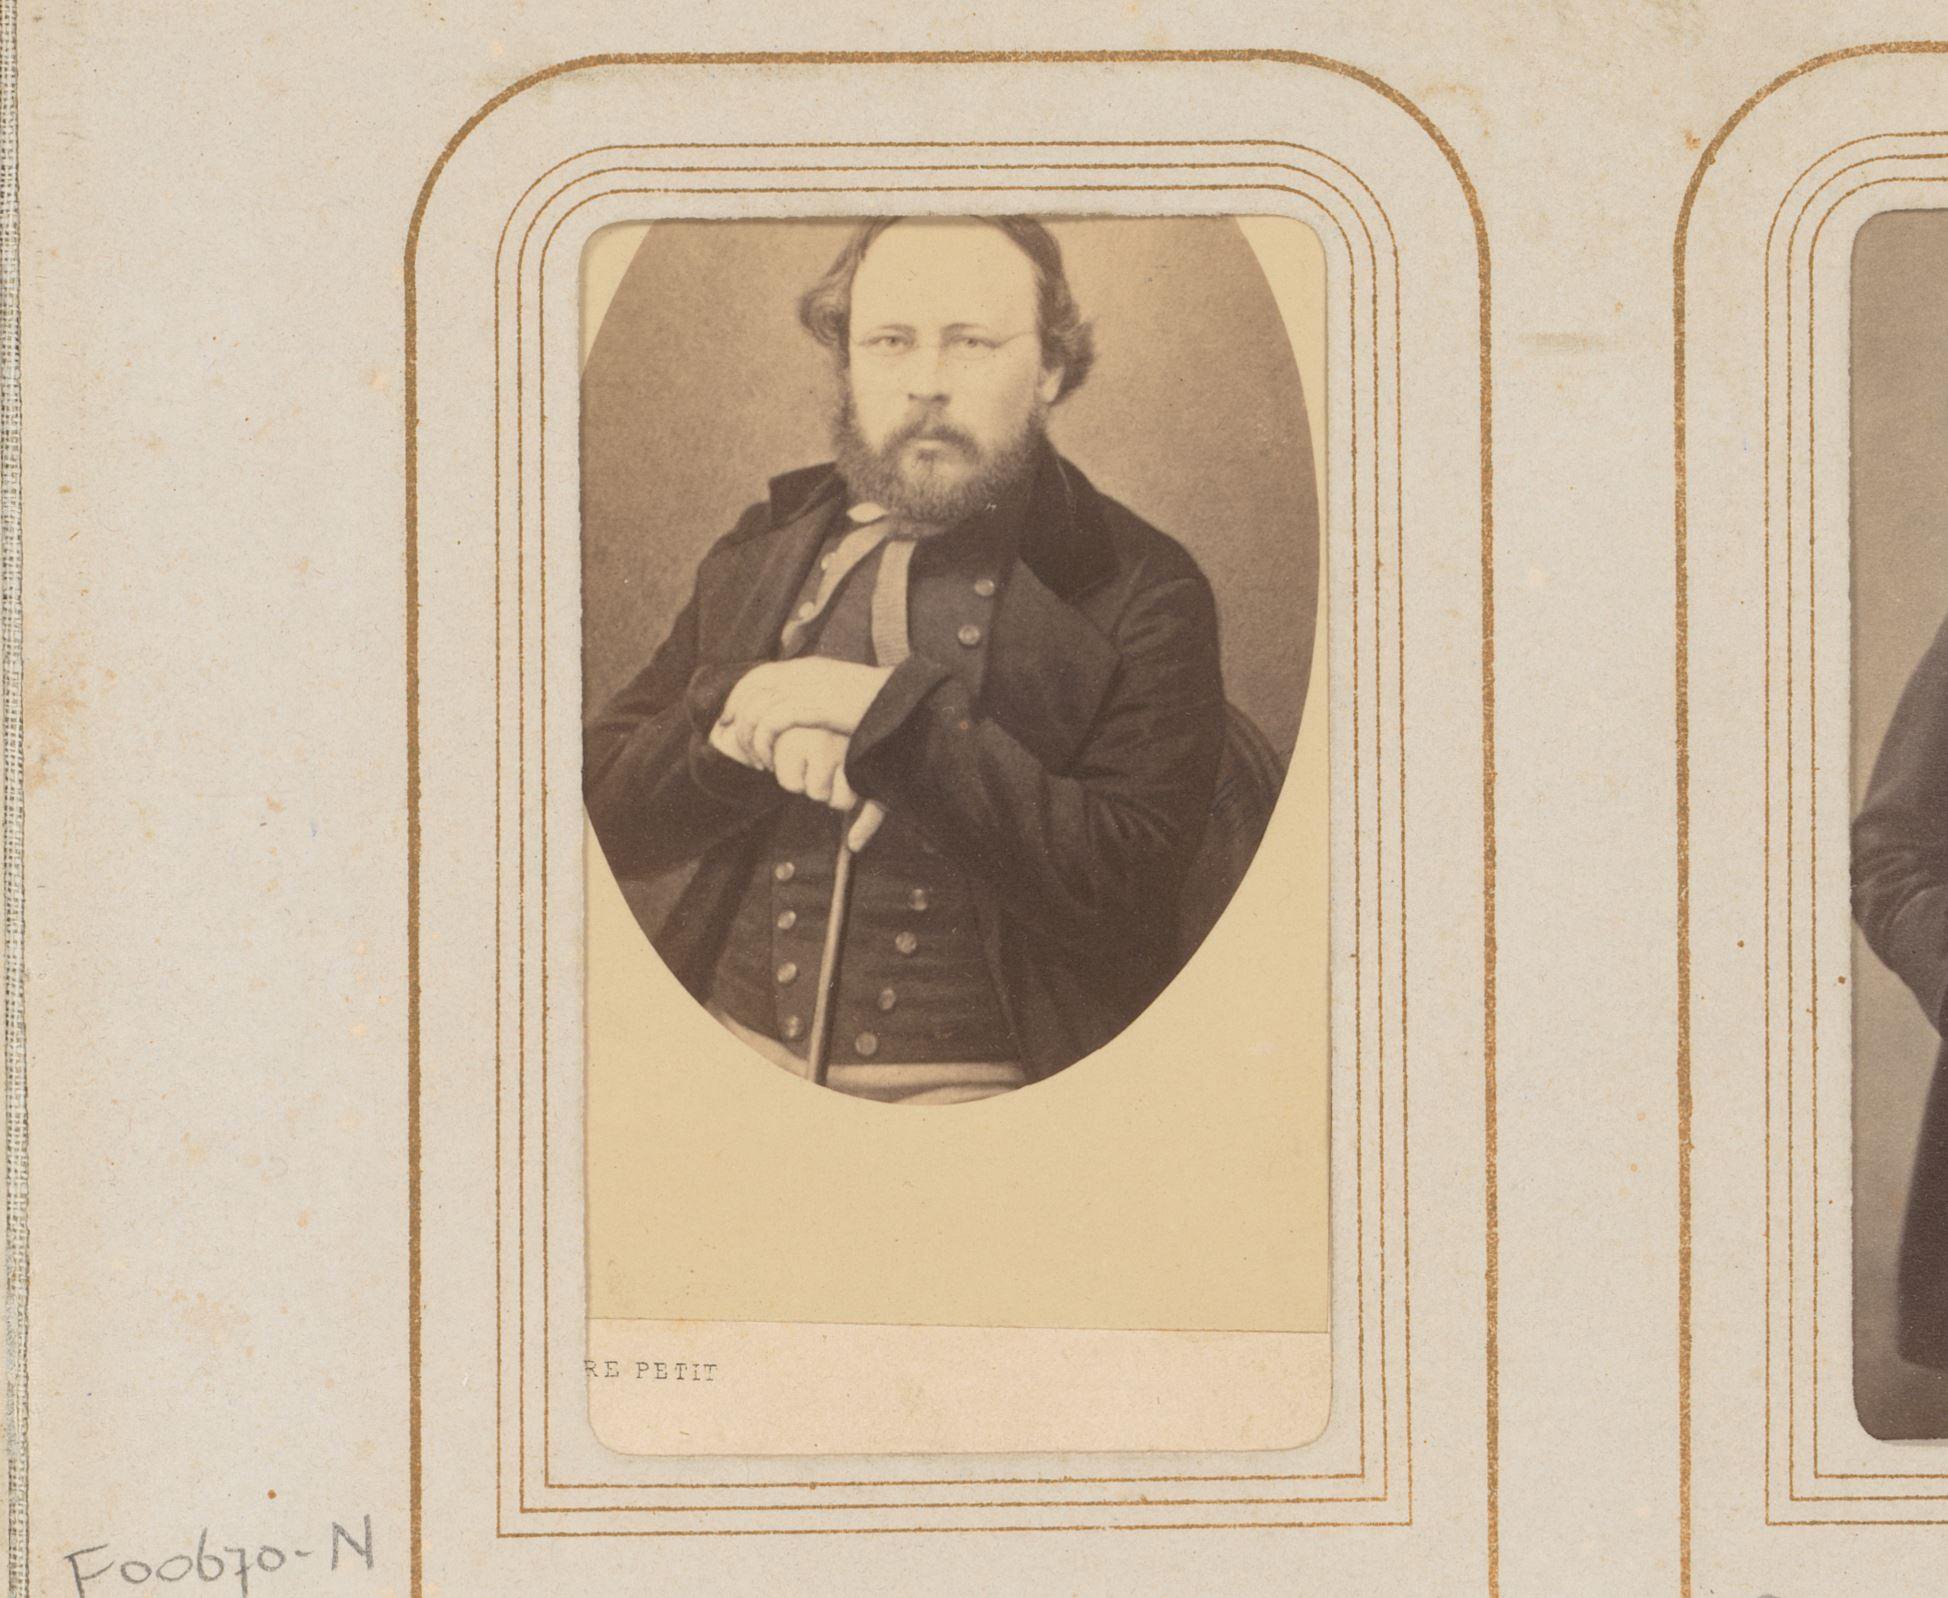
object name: carte de visite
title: Portret van Pierre-Joseph Proudhon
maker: pierre petit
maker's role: fotograaf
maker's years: 1832-1909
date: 1850-1865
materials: cardboard, photographic support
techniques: albumen print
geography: paris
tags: historical persons, publishing, publisher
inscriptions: annotation: ‘Pierre Joseph Proudhon/ fr. publicist 1809-1864 (Petit)’, inscription: ‘Paris Besançon/ Pierre Petit/ Photographe/ 31, Place Cadet/ Paris’